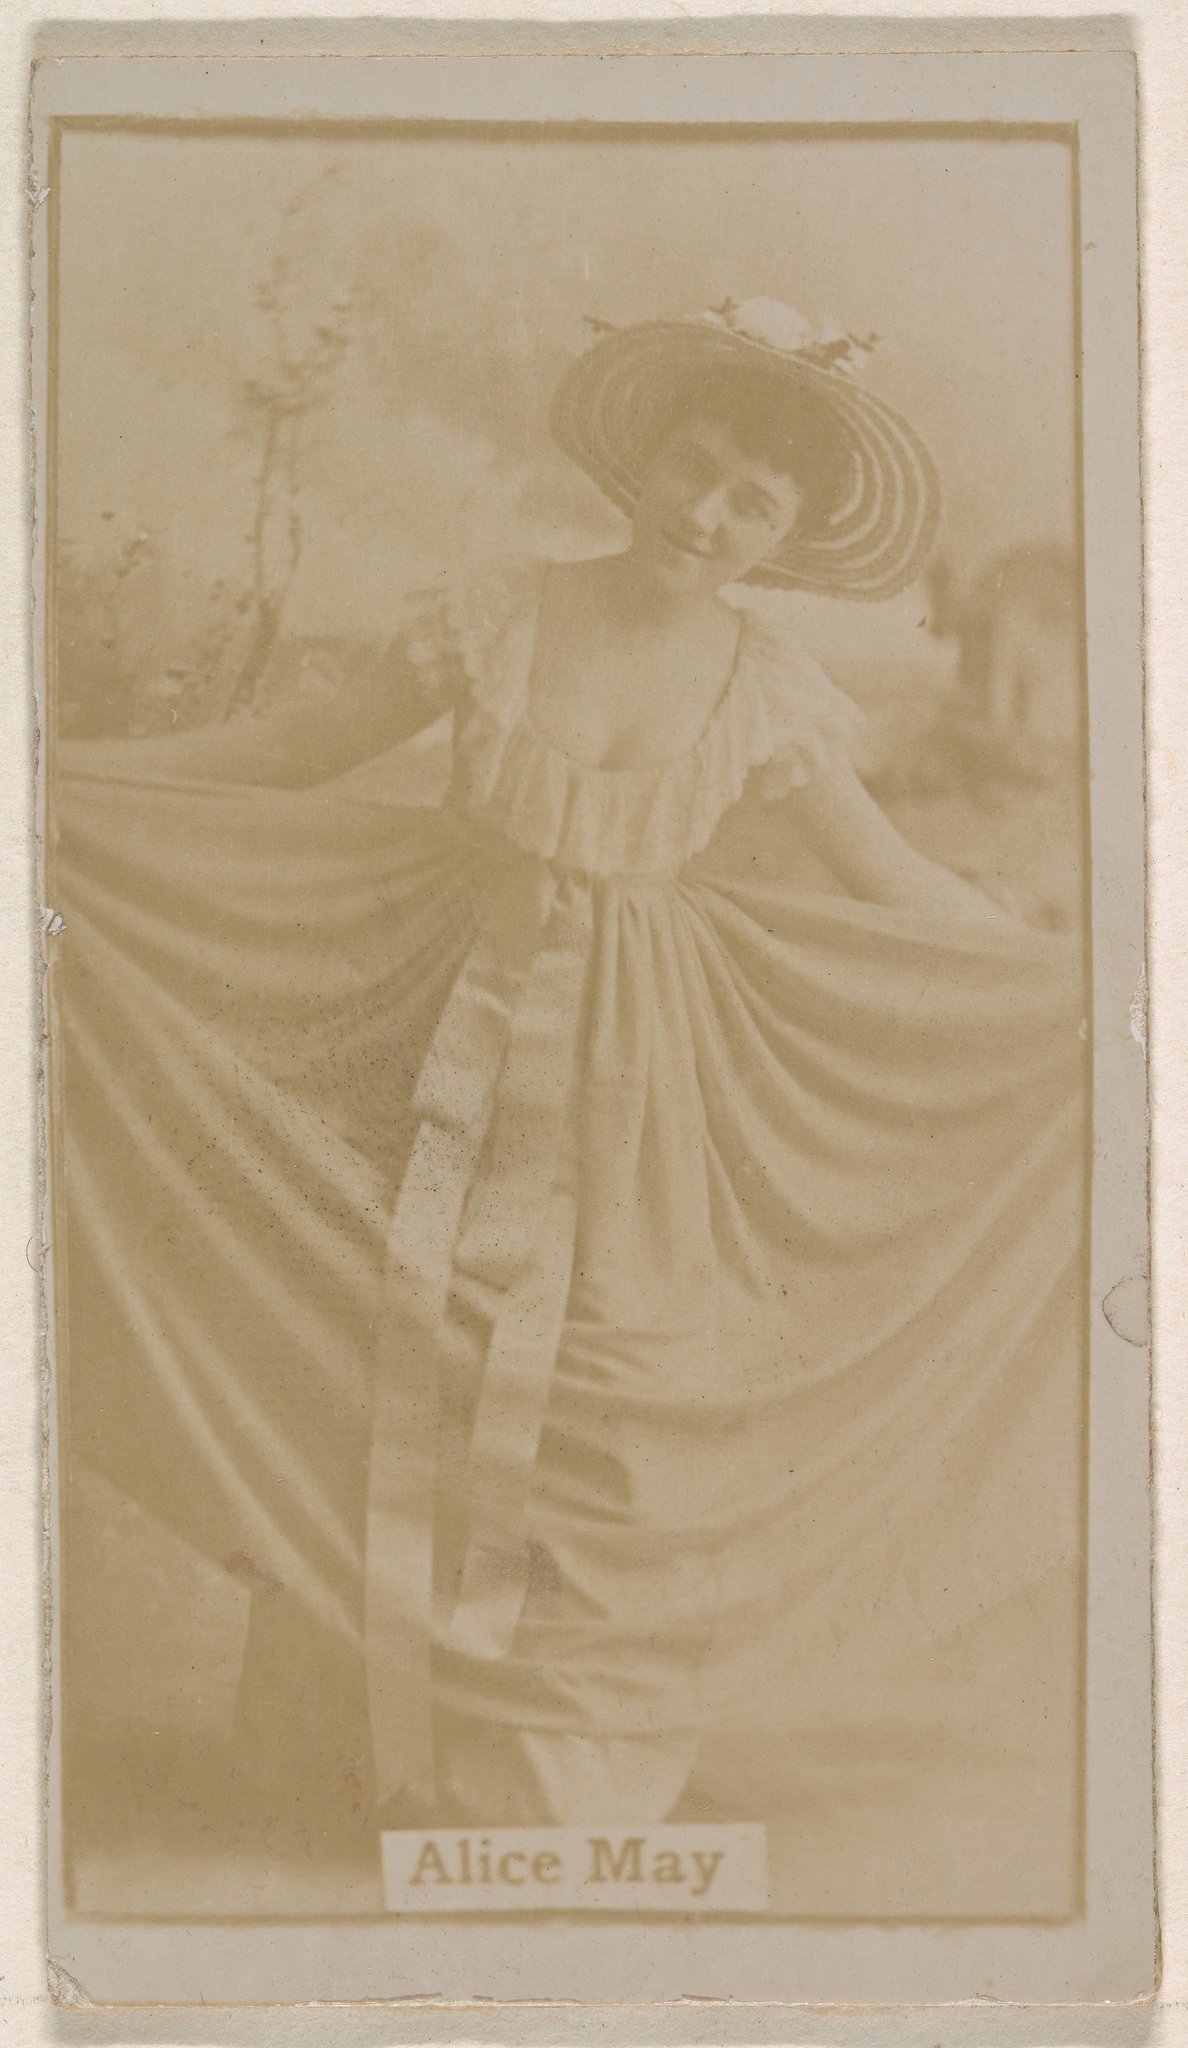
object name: photograph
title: Alice May, from the Actresses series (N245) issued by Kinney Brothers to promote Sweet Caporal Cigarettes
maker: kinney brothers tobacco company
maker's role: publisher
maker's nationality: american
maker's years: 1869-2011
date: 1890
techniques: albumen silver print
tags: portraits,women,actresses